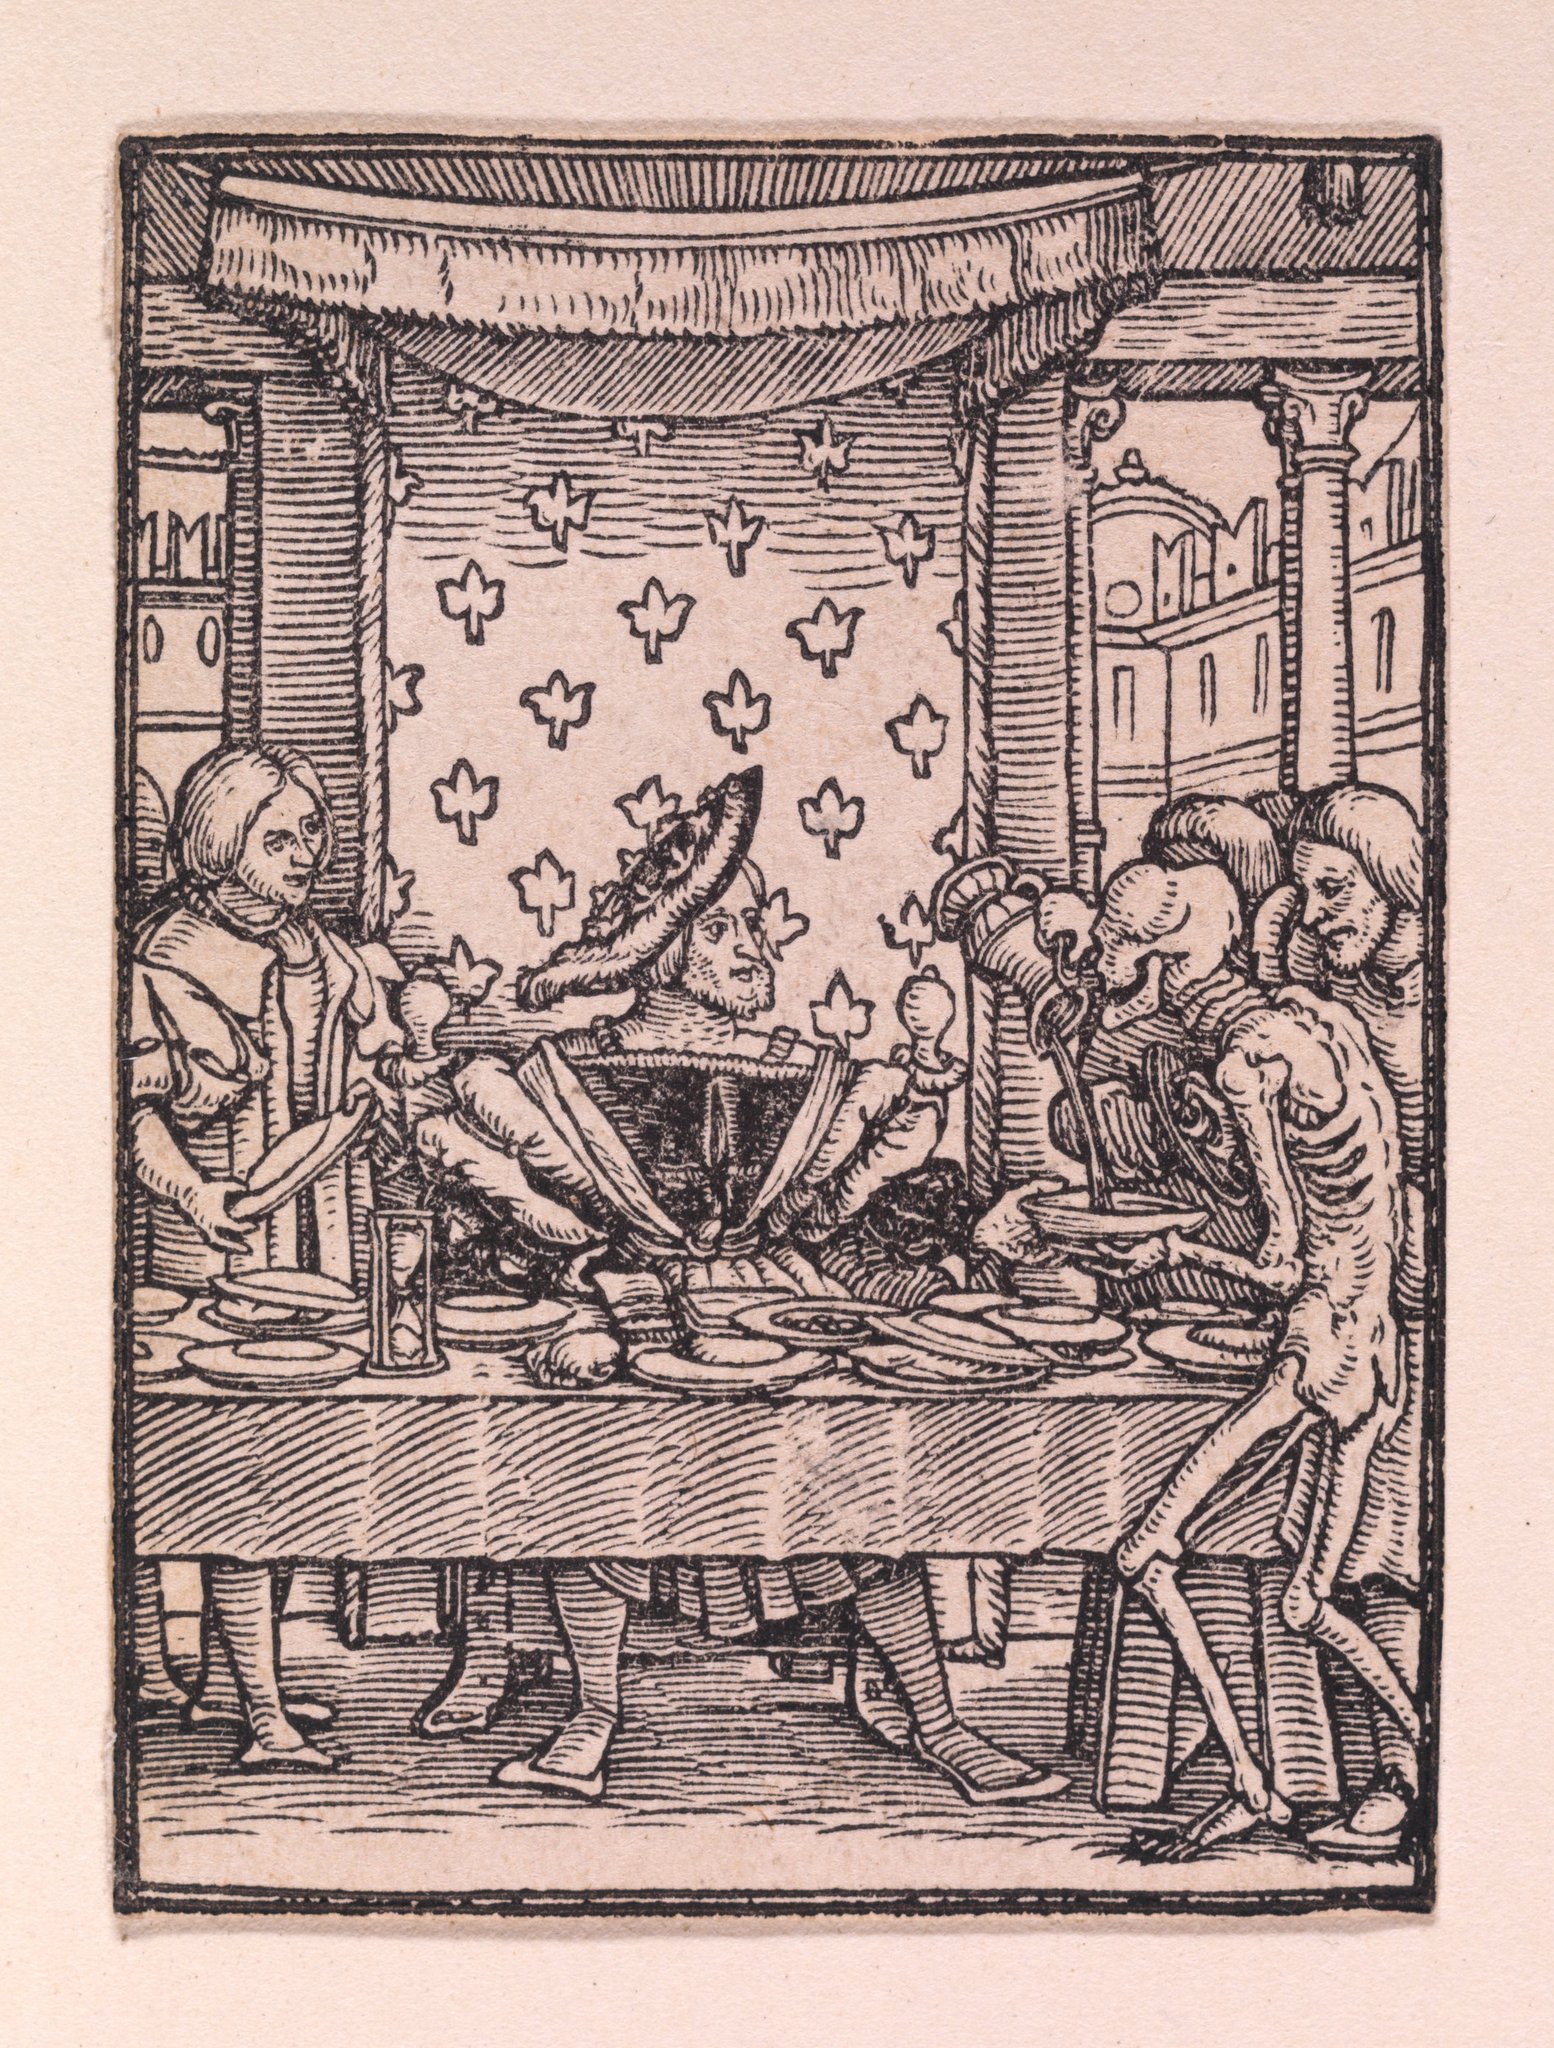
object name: print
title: The King, from "The Dance of Death"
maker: hans holbein the younger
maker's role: artist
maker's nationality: german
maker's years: 1497-1543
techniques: woodcut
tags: food,kings,skeletons,men,death,hourglass